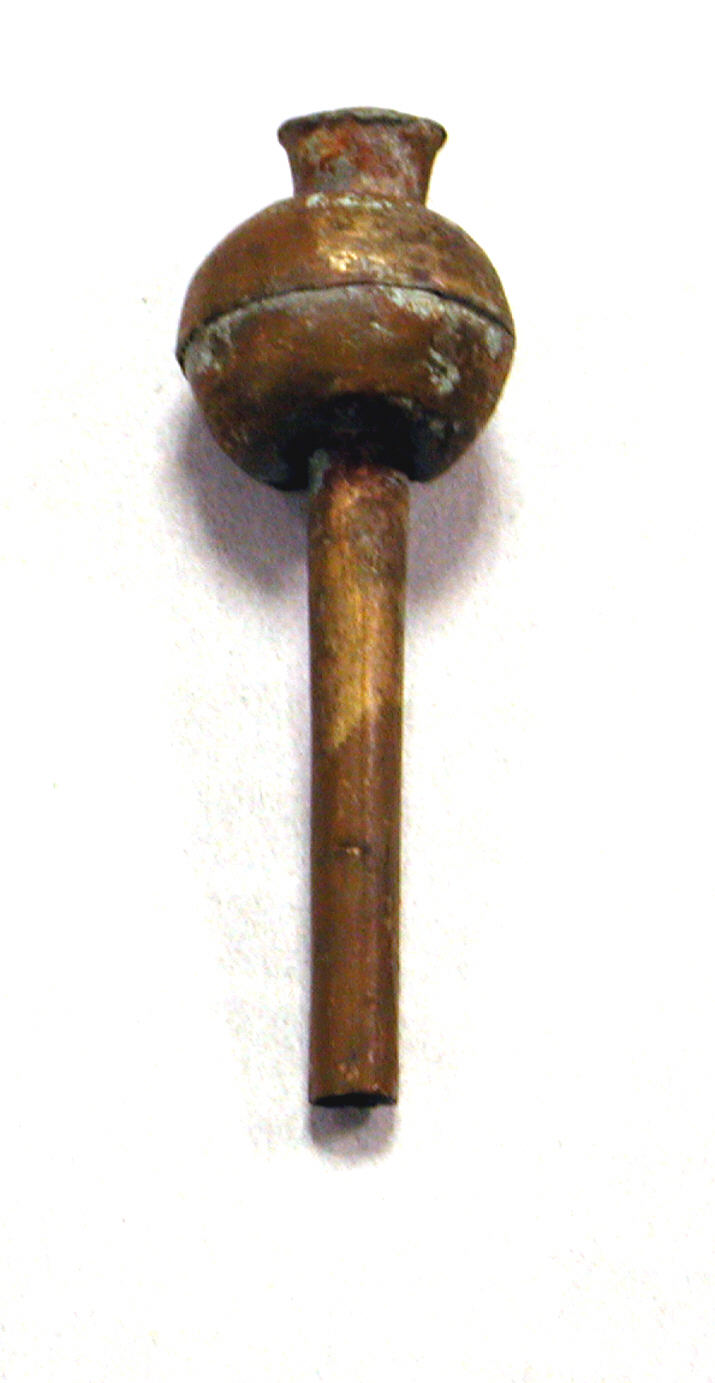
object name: scepter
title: Hammered Silver Miniature Scepter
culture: peruvian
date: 701-1566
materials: copper, gilt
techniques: hammering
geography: peru